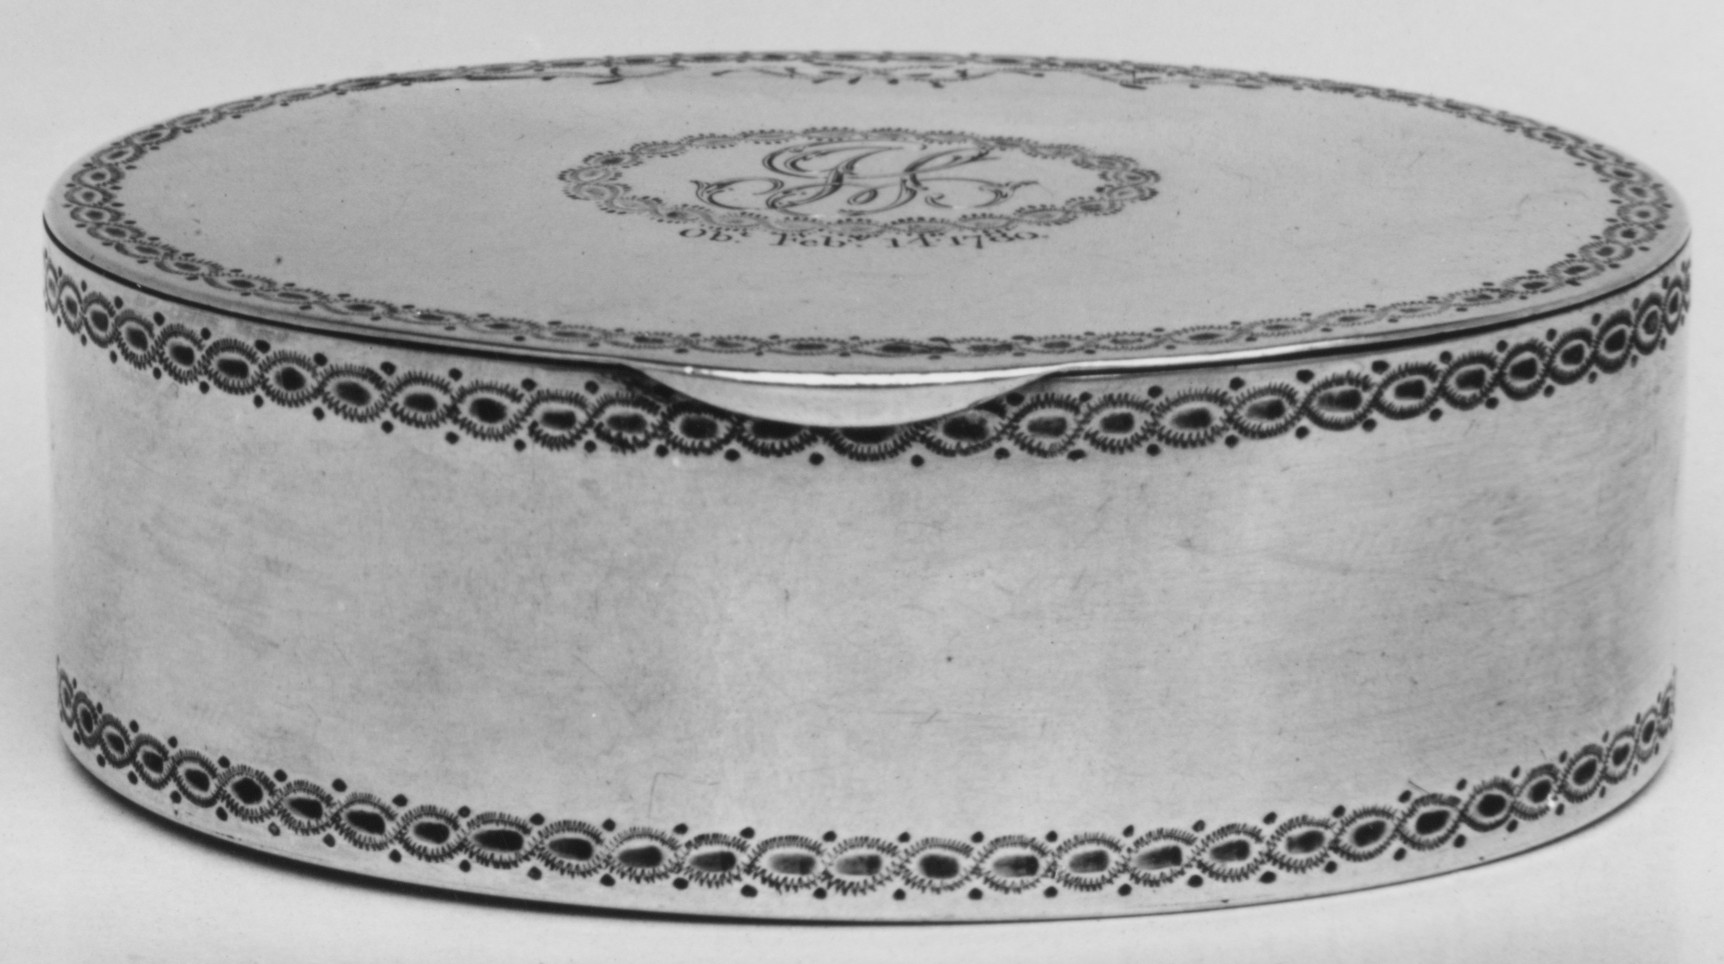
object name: box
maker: a. l.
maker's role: maker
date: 1767-1800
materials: silver